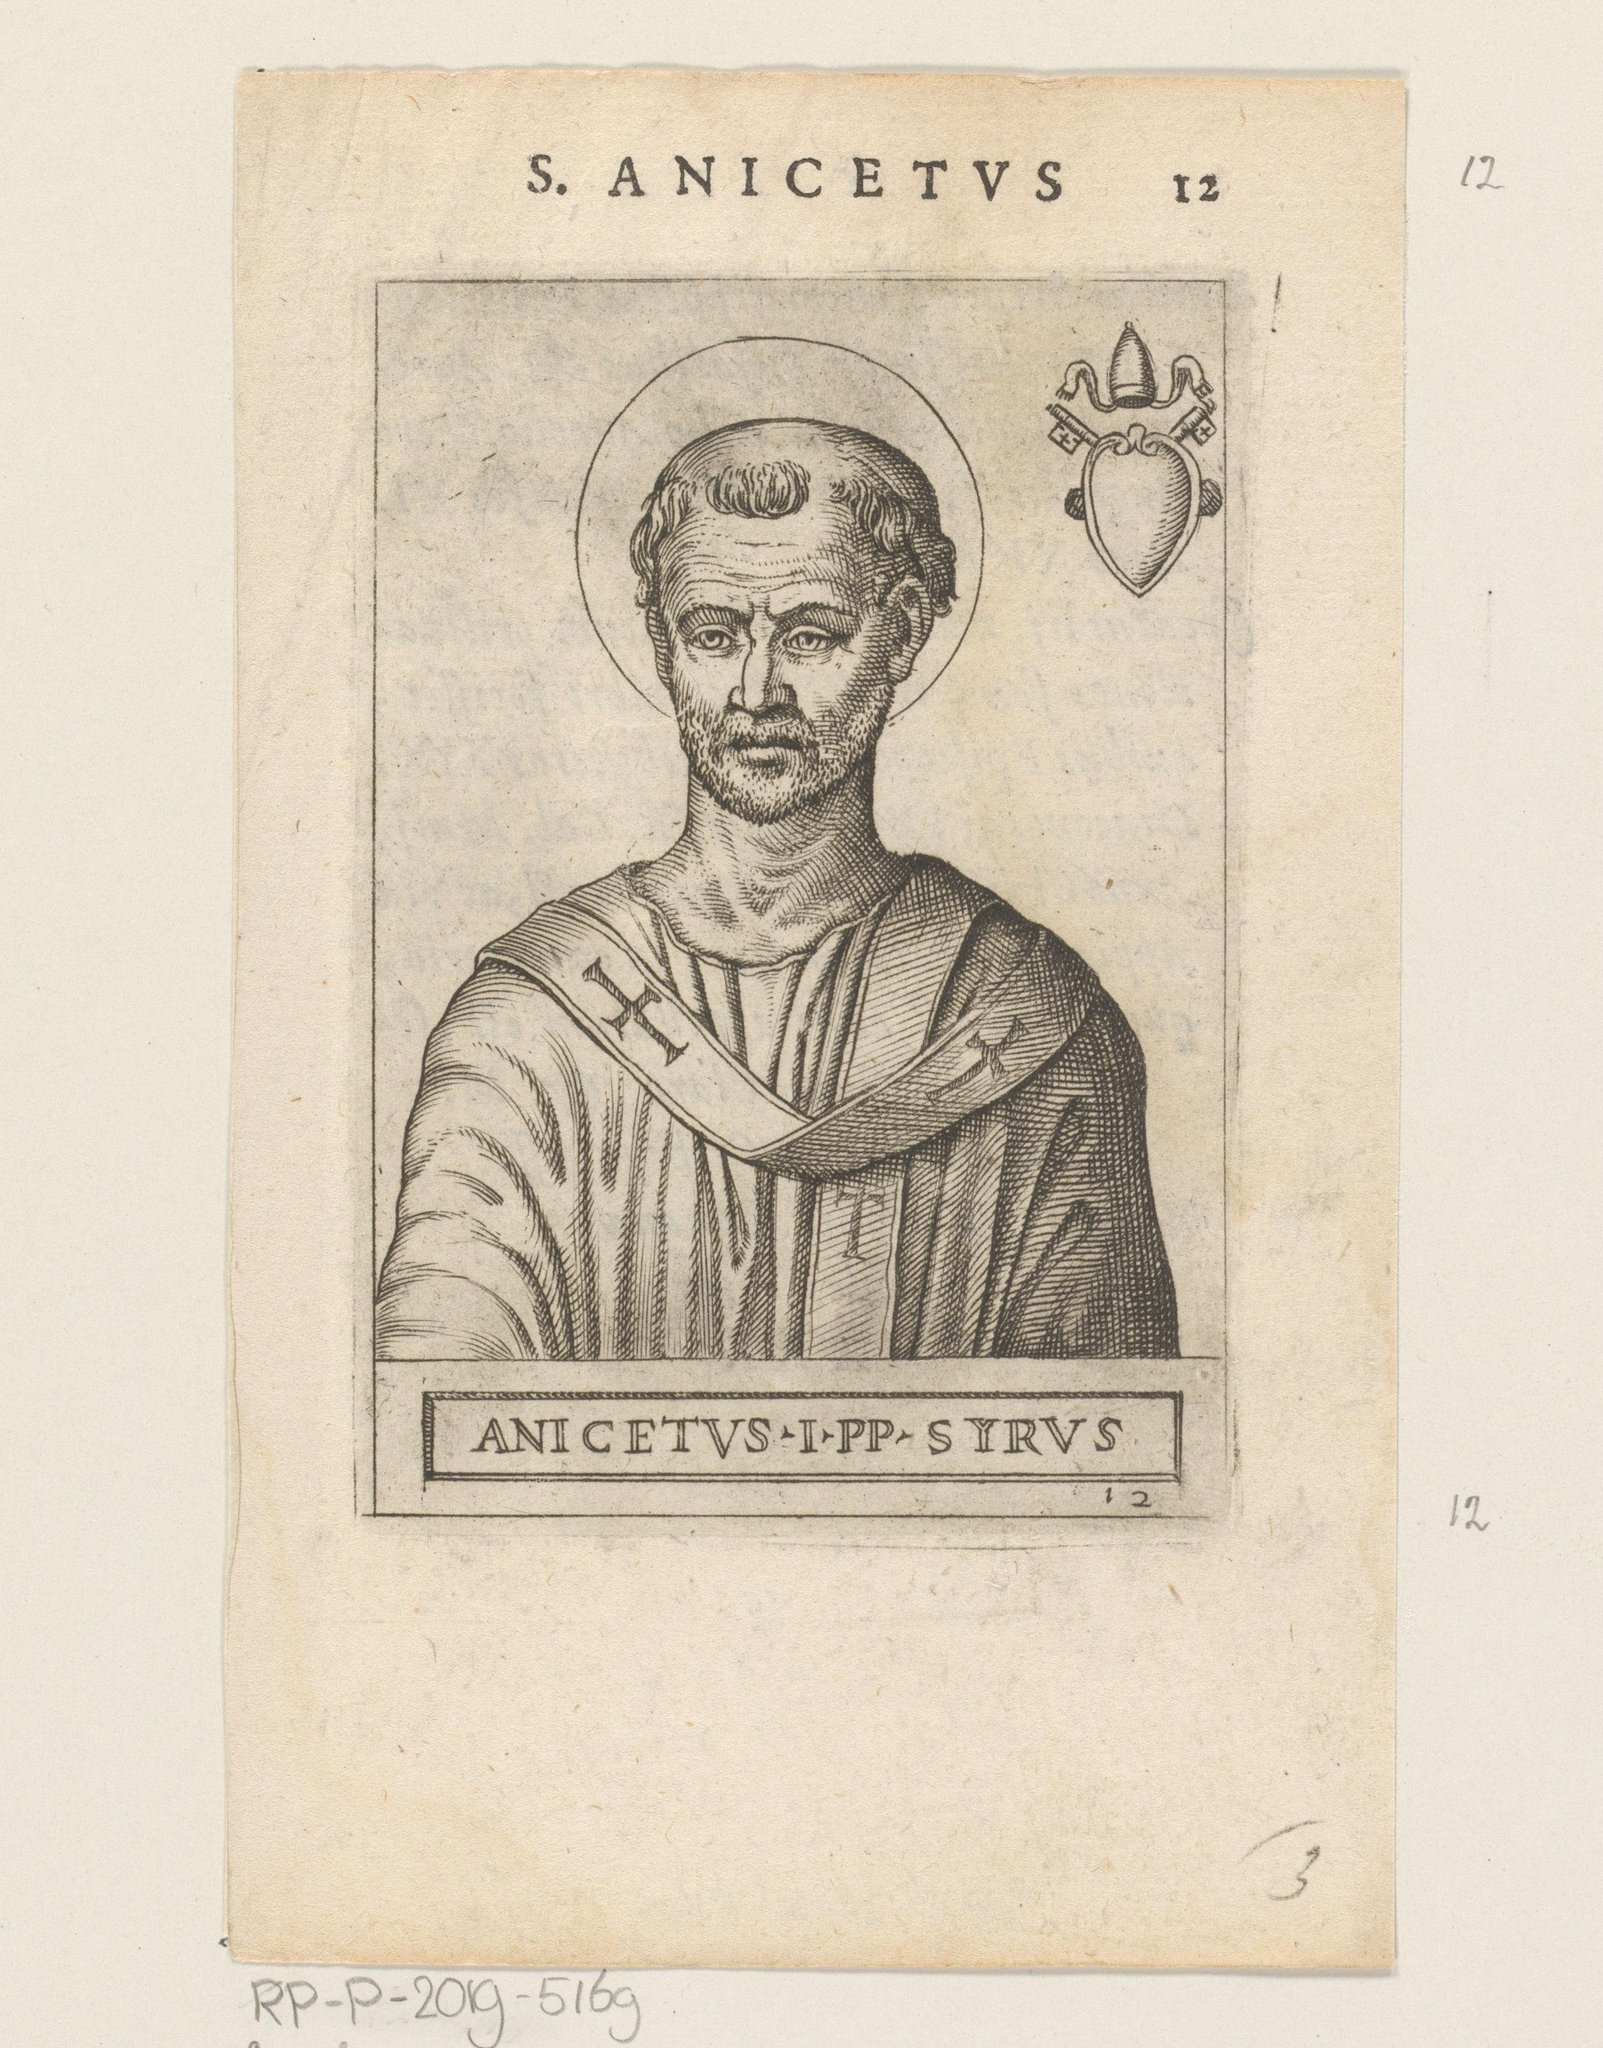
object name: print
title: Portret van paus Anicetus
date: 1595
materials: paper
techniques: engraving, letterpress printing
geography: rome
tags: historical persons, pope, armorial bearing, heraldry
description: Prent uit: Cavalieri, Giovanni Battista de'. Effigies pontificum romanorum cum eorum vitis (...). Rome: Bartolomeo Bonfadino, 1595. Prent voor het eerst verschenen in: Cavalieri, Giovanni Battista de'. Pontificum romanorum effigies (...). Rome: Domenico Basa en Francesco Zanetti, 1580. Prent ook gebruikt in latere publicaties.